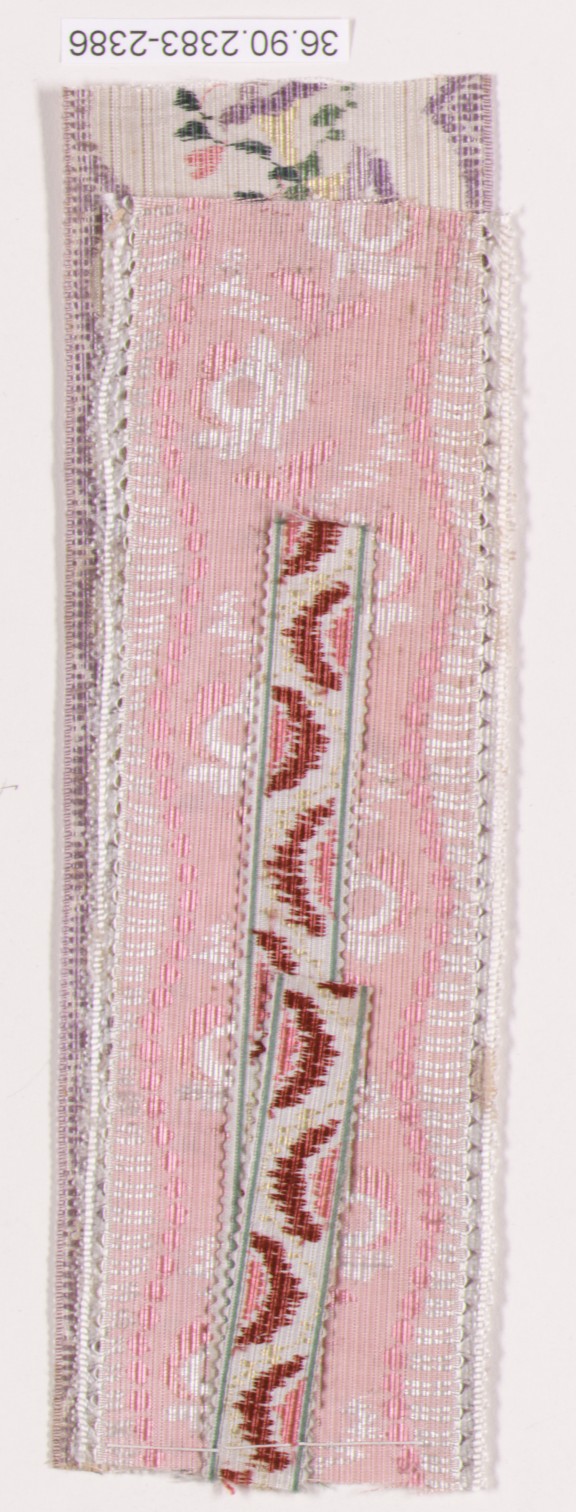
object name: ribbon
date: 1801-1900